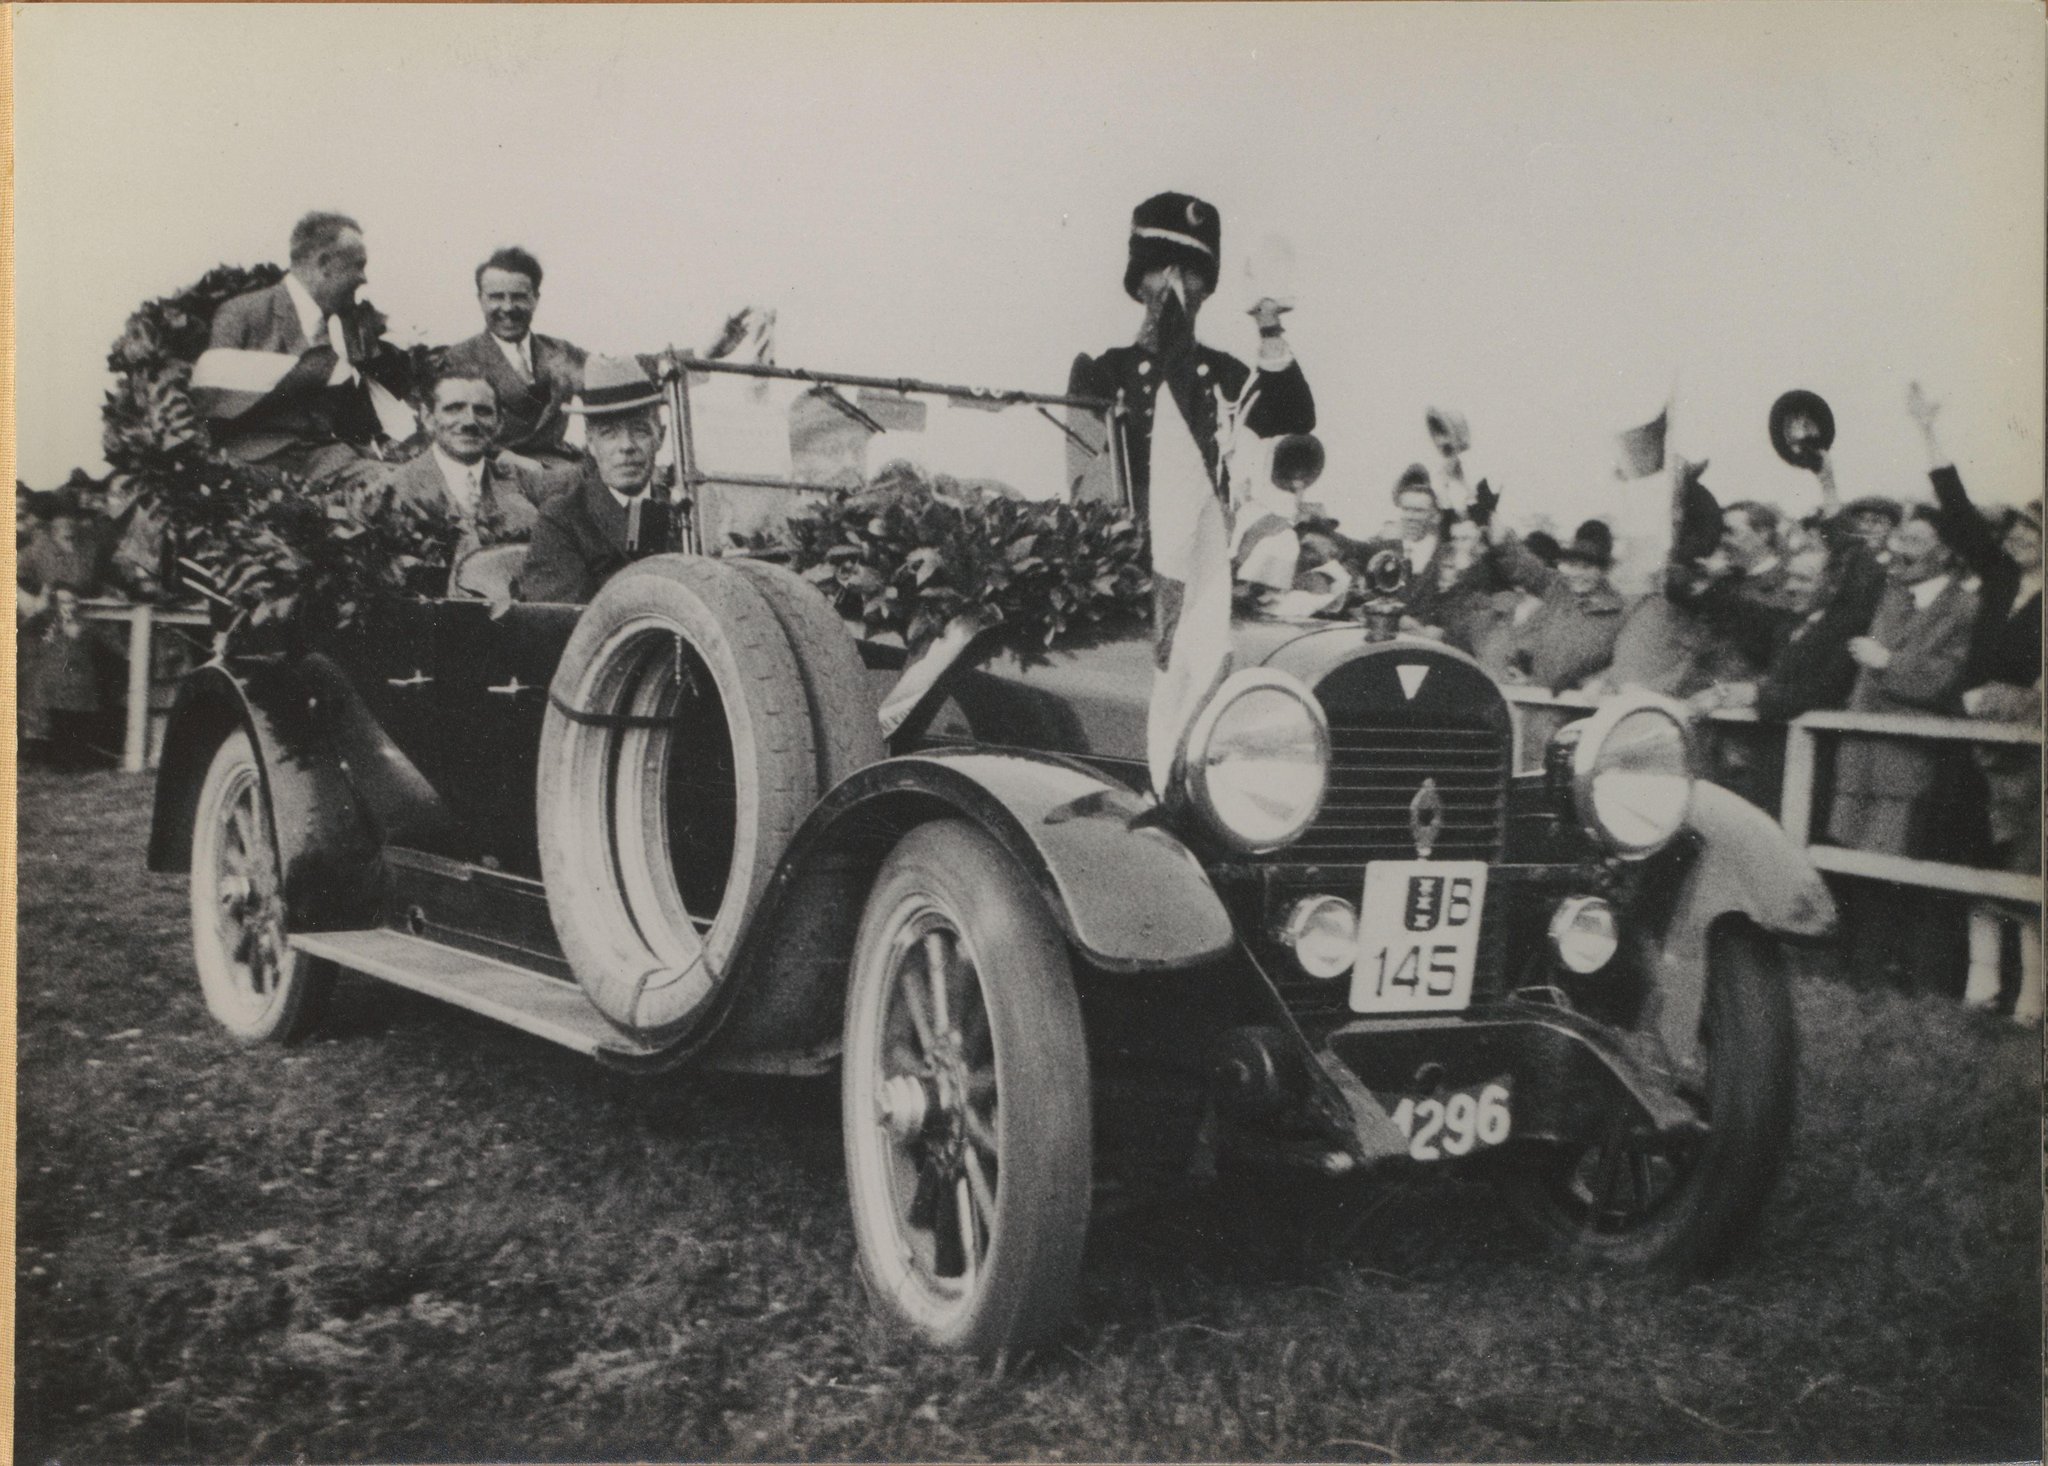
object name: album leaf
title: Inhuldiging, vermoedelijk op Schiphol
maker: Anonymous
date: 1925-1930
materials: cardboard, paper, photographic support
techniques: gelatin silver print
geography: schiphol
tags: airborne traffic, aviation, travelling; tourism, automobile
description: Albumblad met een foto van een inhuldiging van drie mannen in een auto. Onderdeel van Herdenkingsalbum van de Indië-lijn van de KLM, deel I.